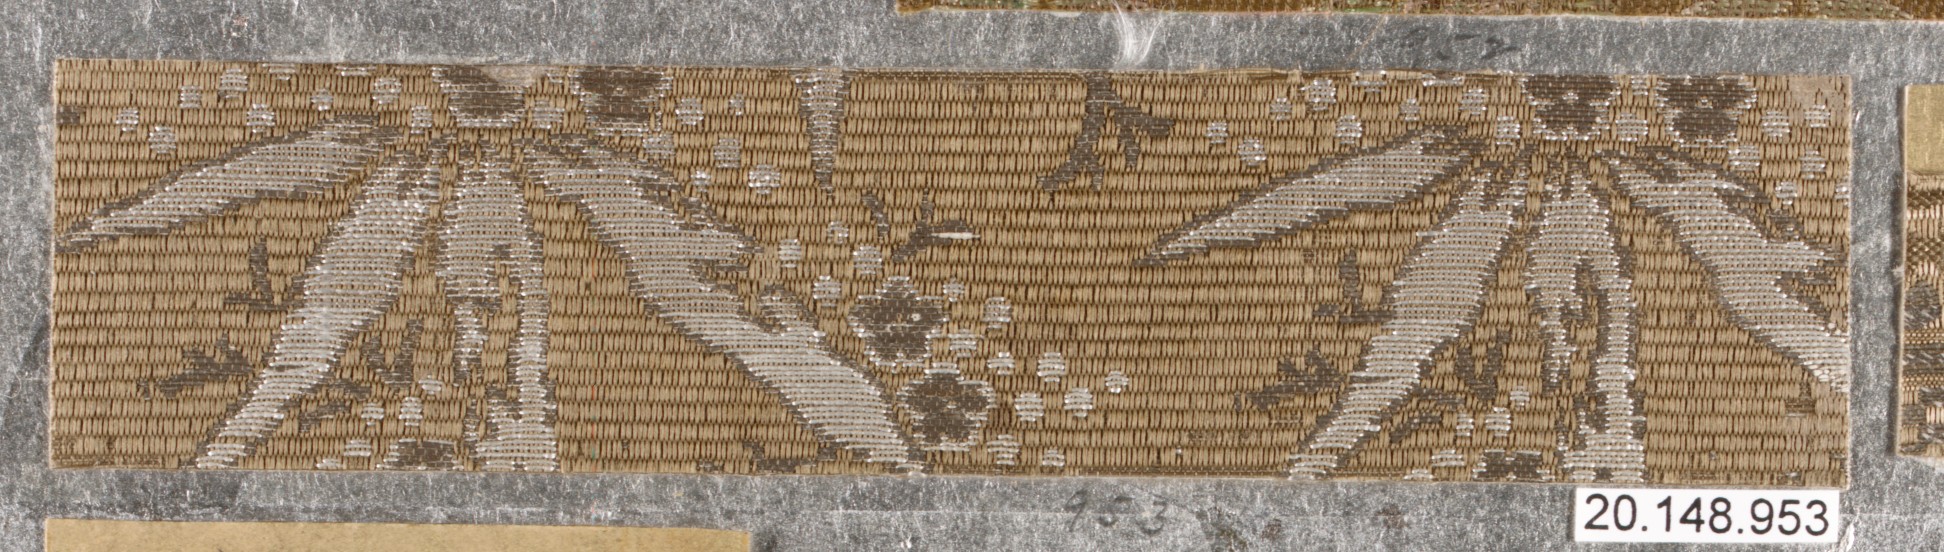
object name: piece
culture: japanese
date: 1701-1800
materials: silk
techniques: compound weave